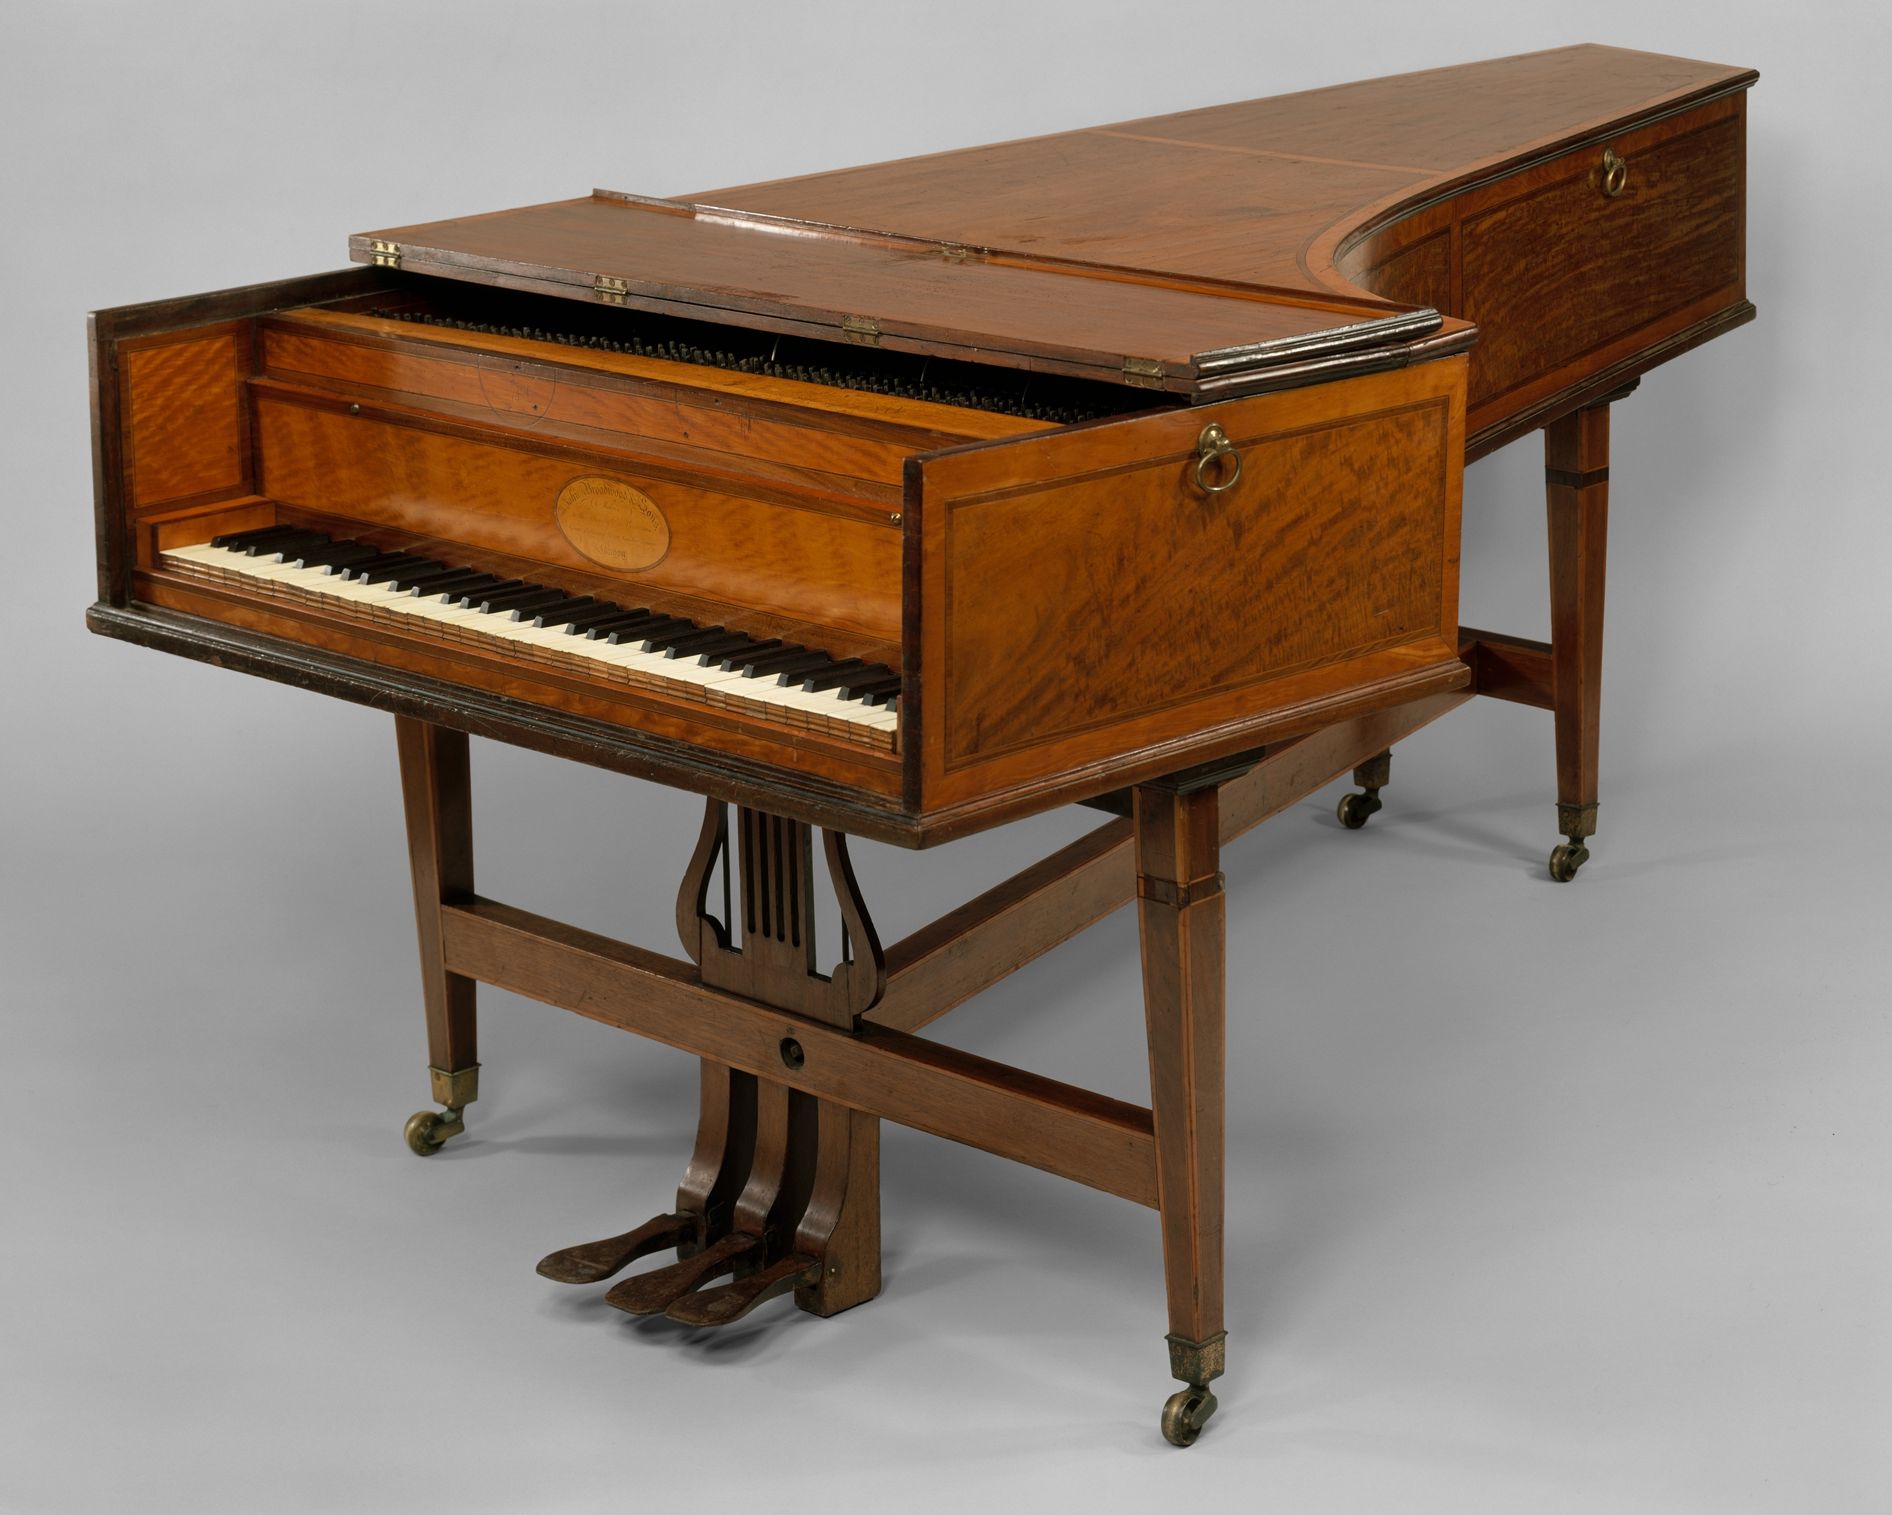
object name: grand piano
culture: british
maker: john broadwood & sons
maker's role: maker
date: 1808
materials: wood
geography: england